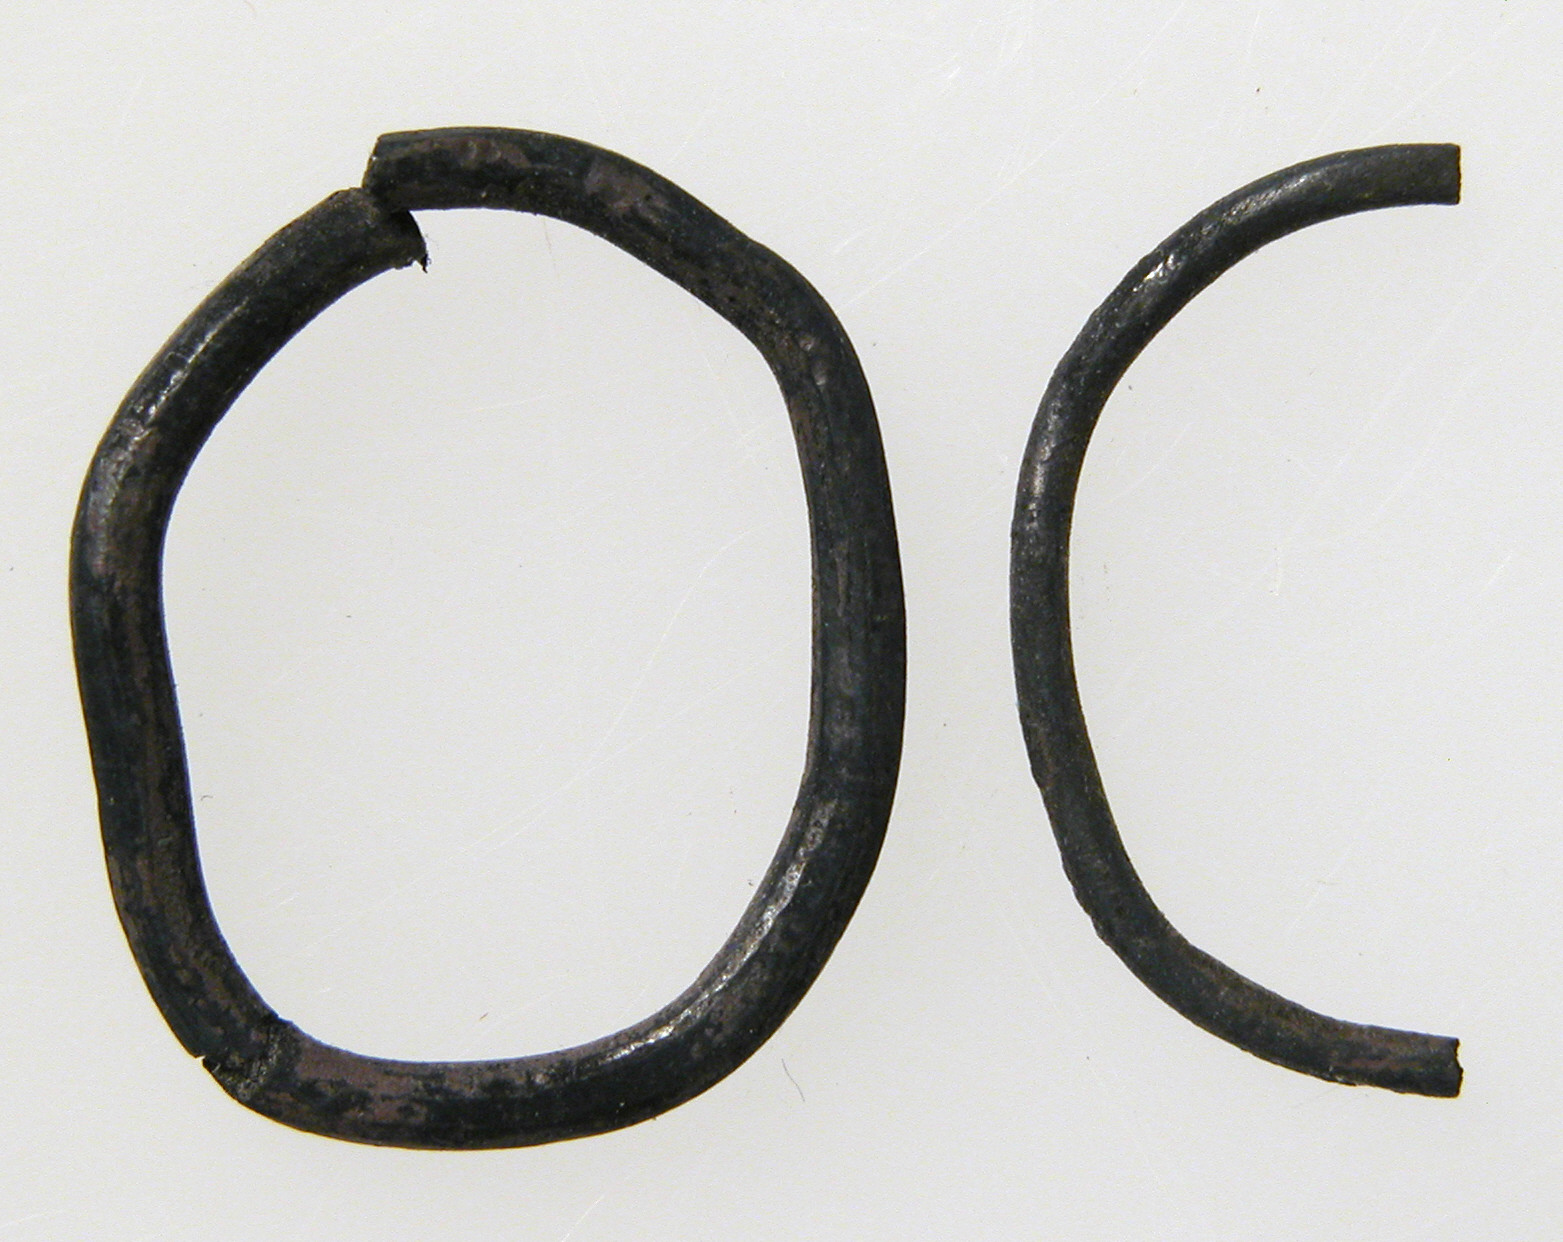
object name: earring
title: Pair of Earrings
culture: coptic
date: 301-700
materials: alloy, silver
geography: egypt